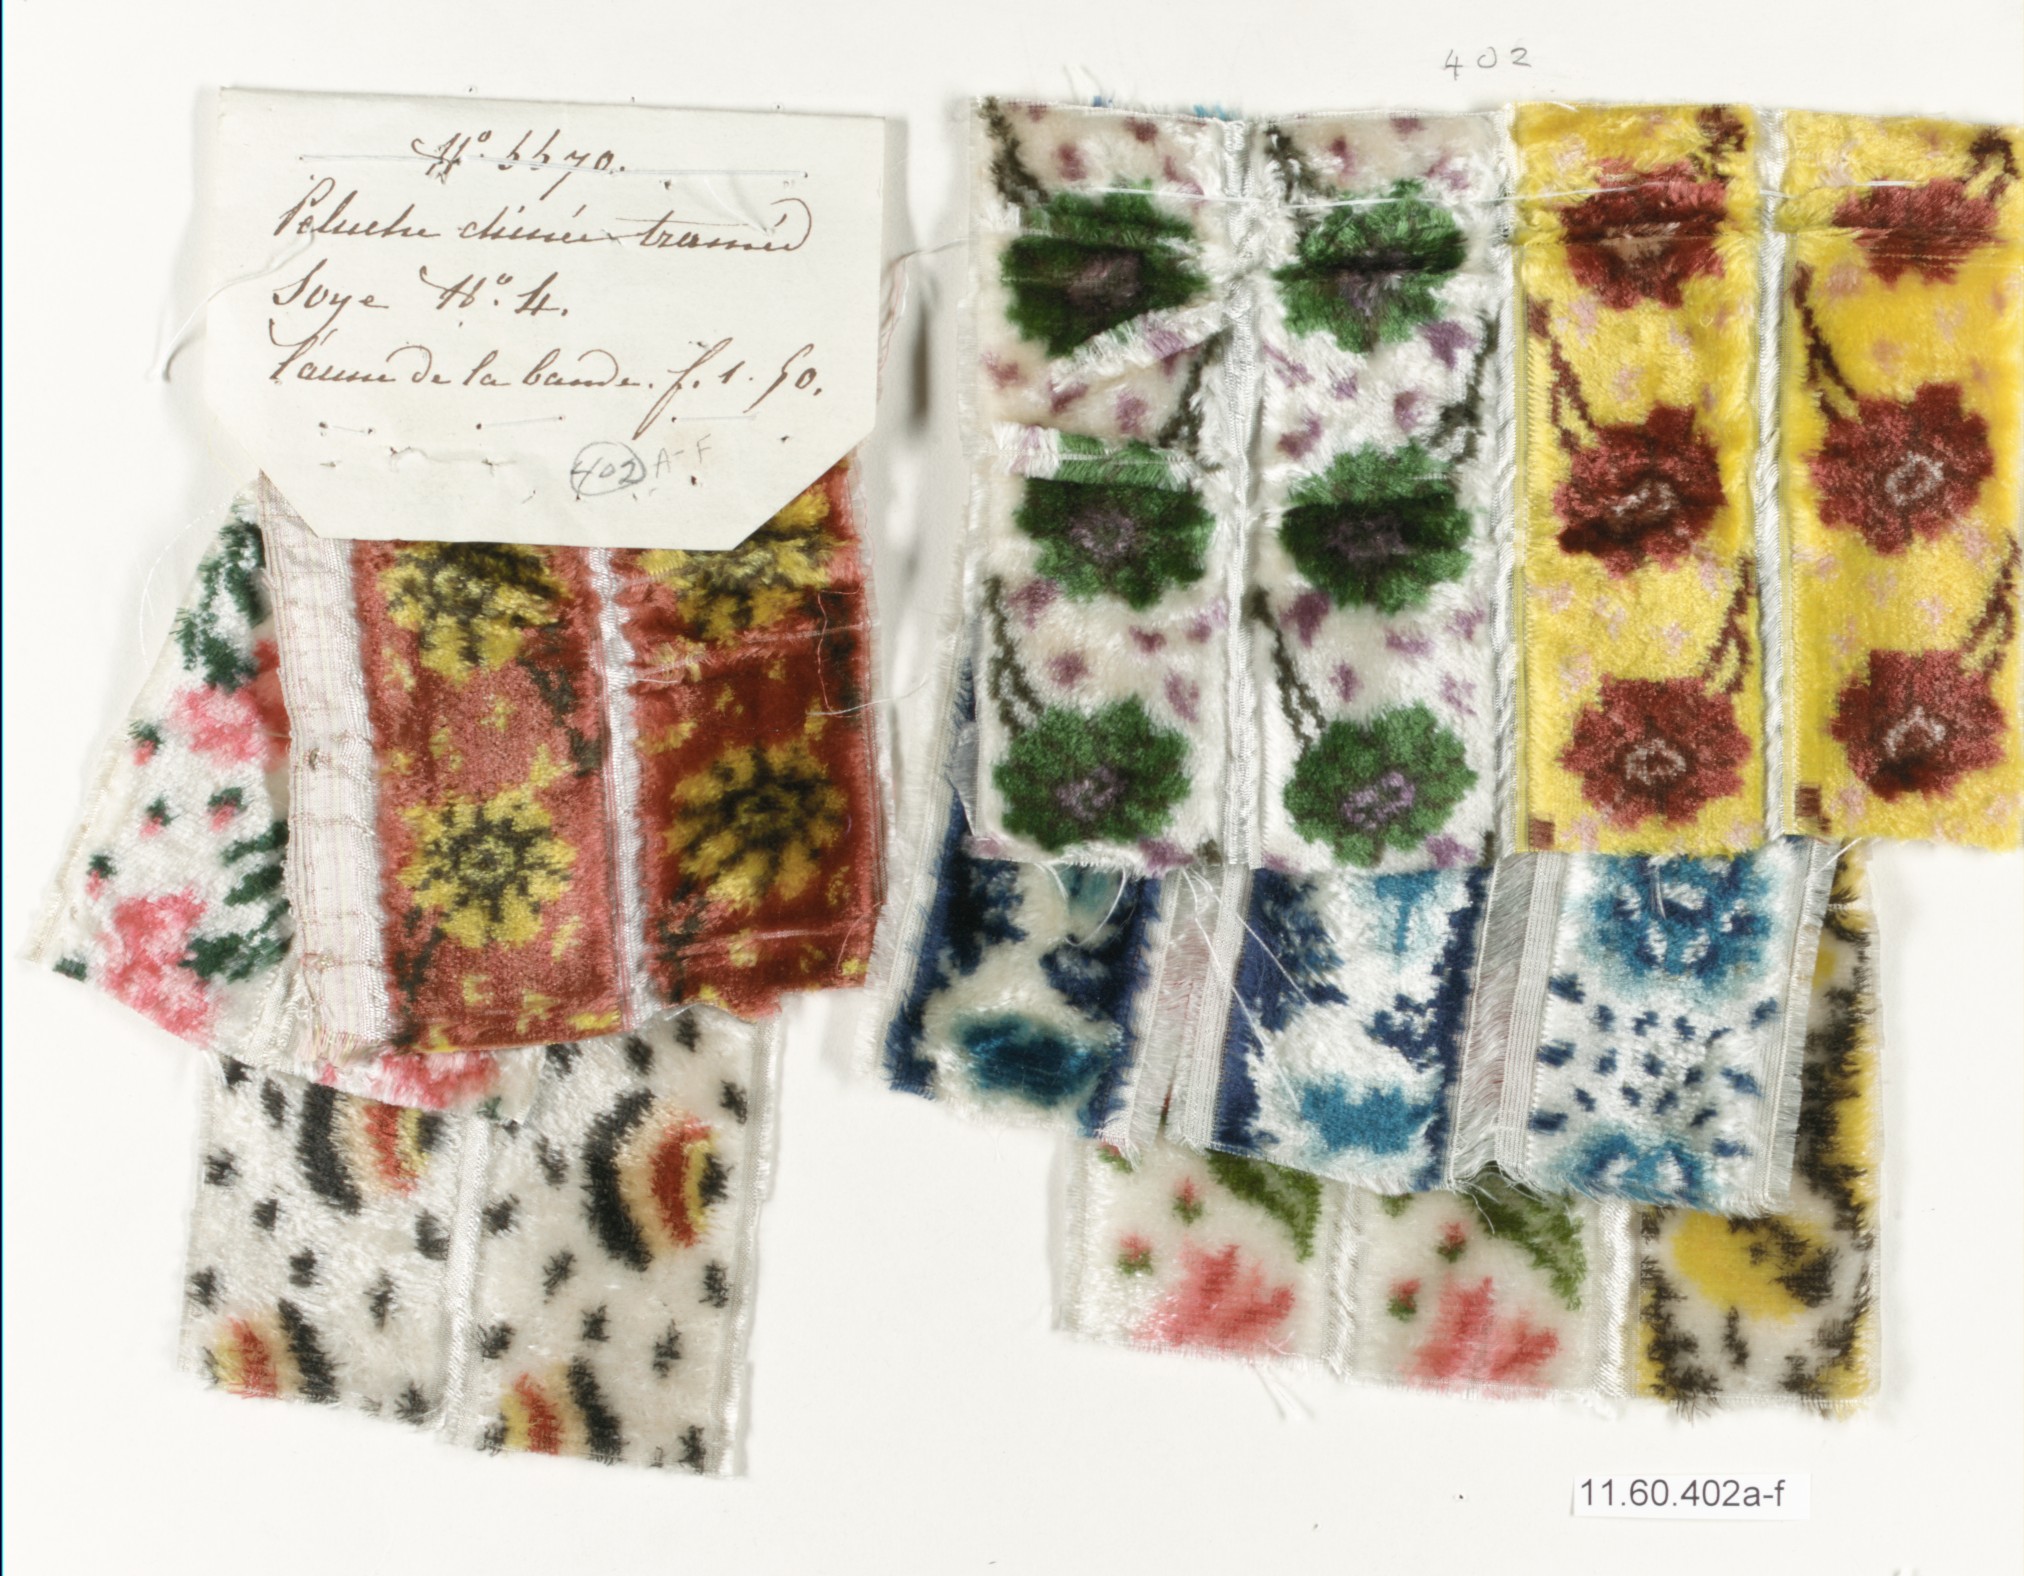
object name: fragment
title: Fragments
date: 1801-1900